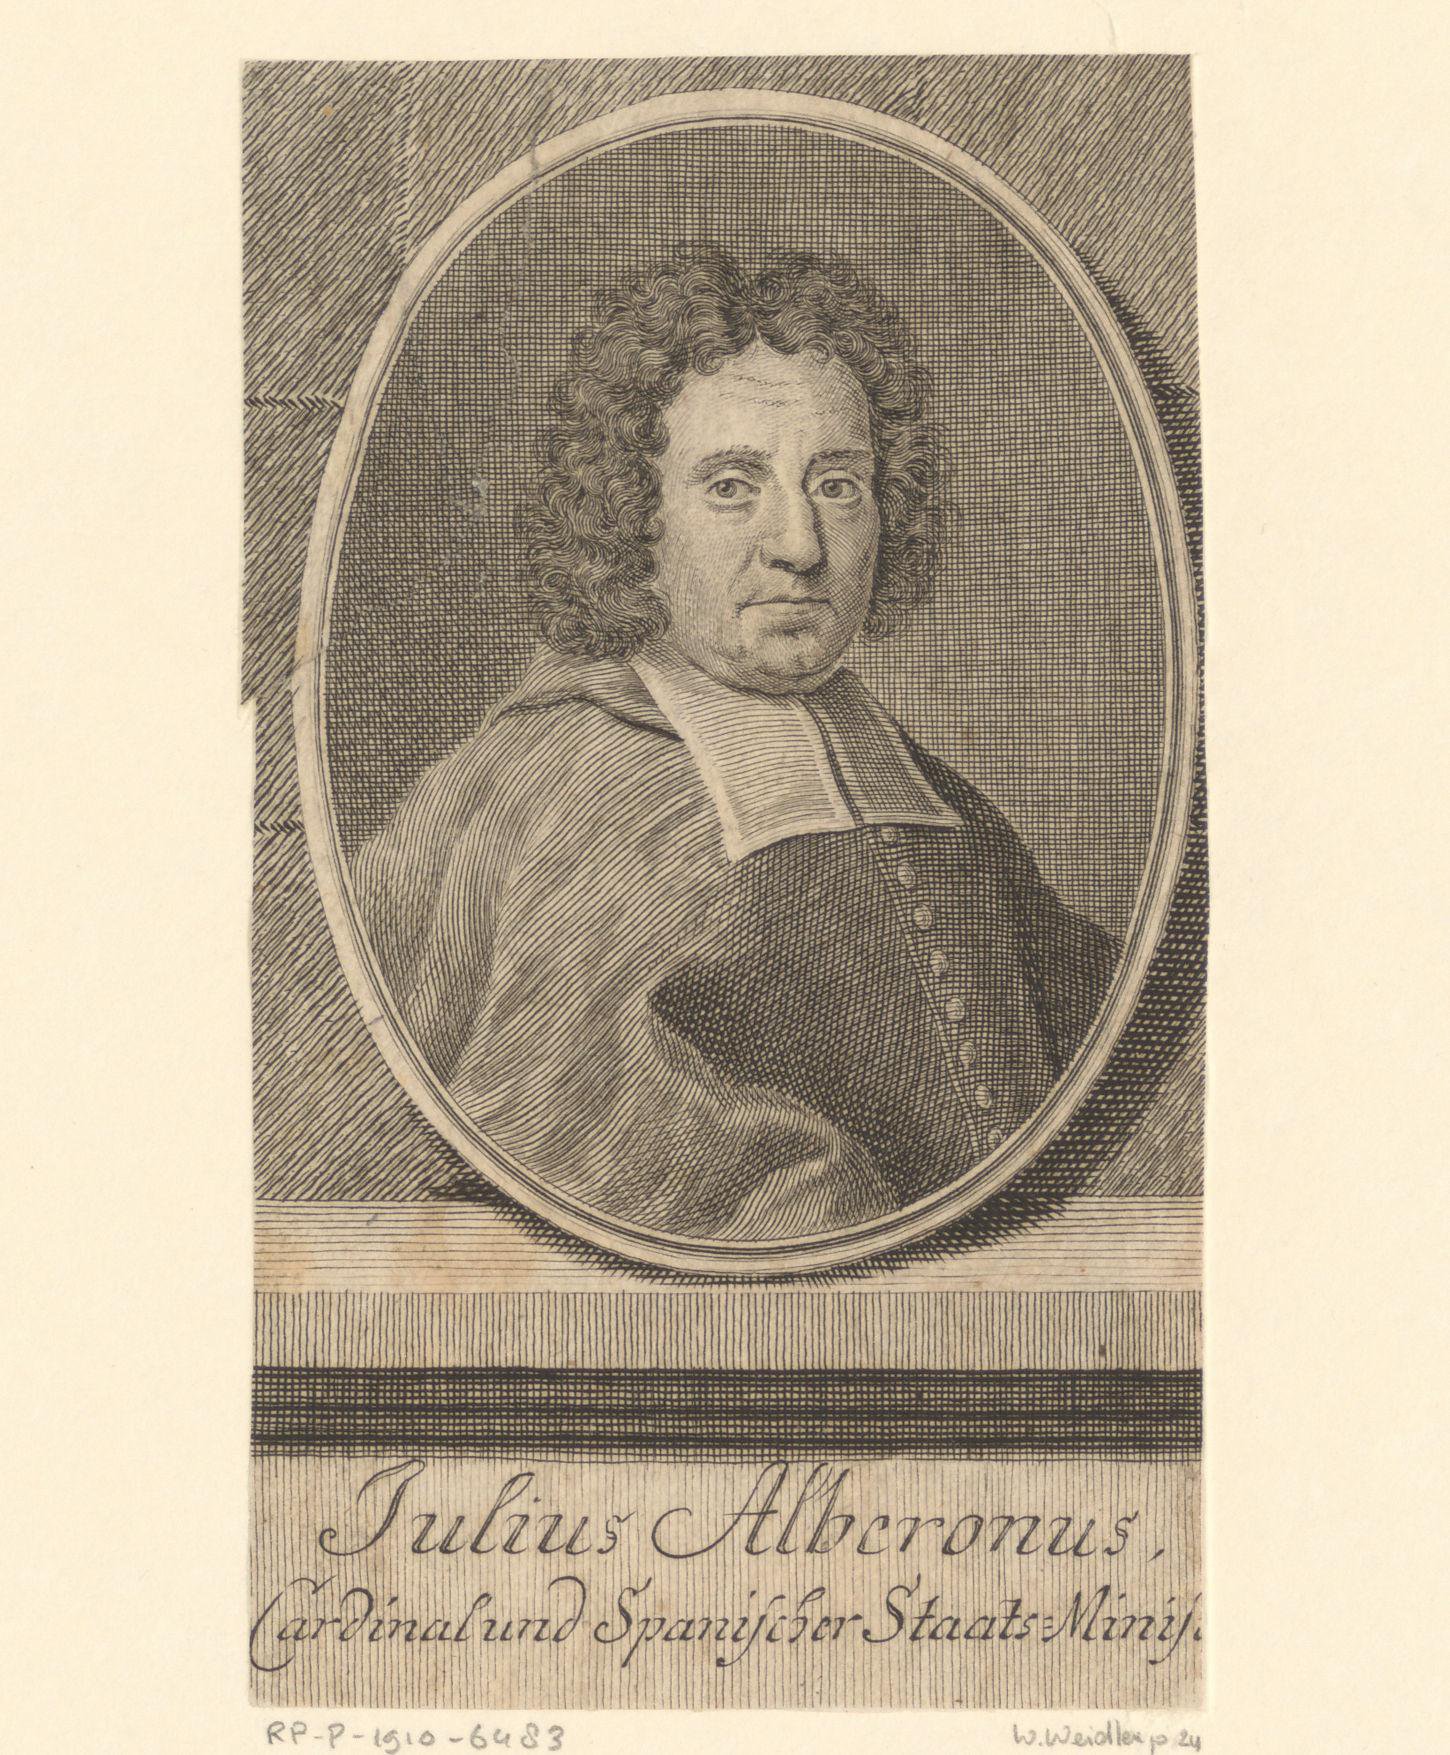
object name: print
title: Portret van Giulio Alberoni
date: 1715-1767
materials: paper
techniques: engraving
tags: historical persons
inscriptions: collector's mark: Lugt 2228